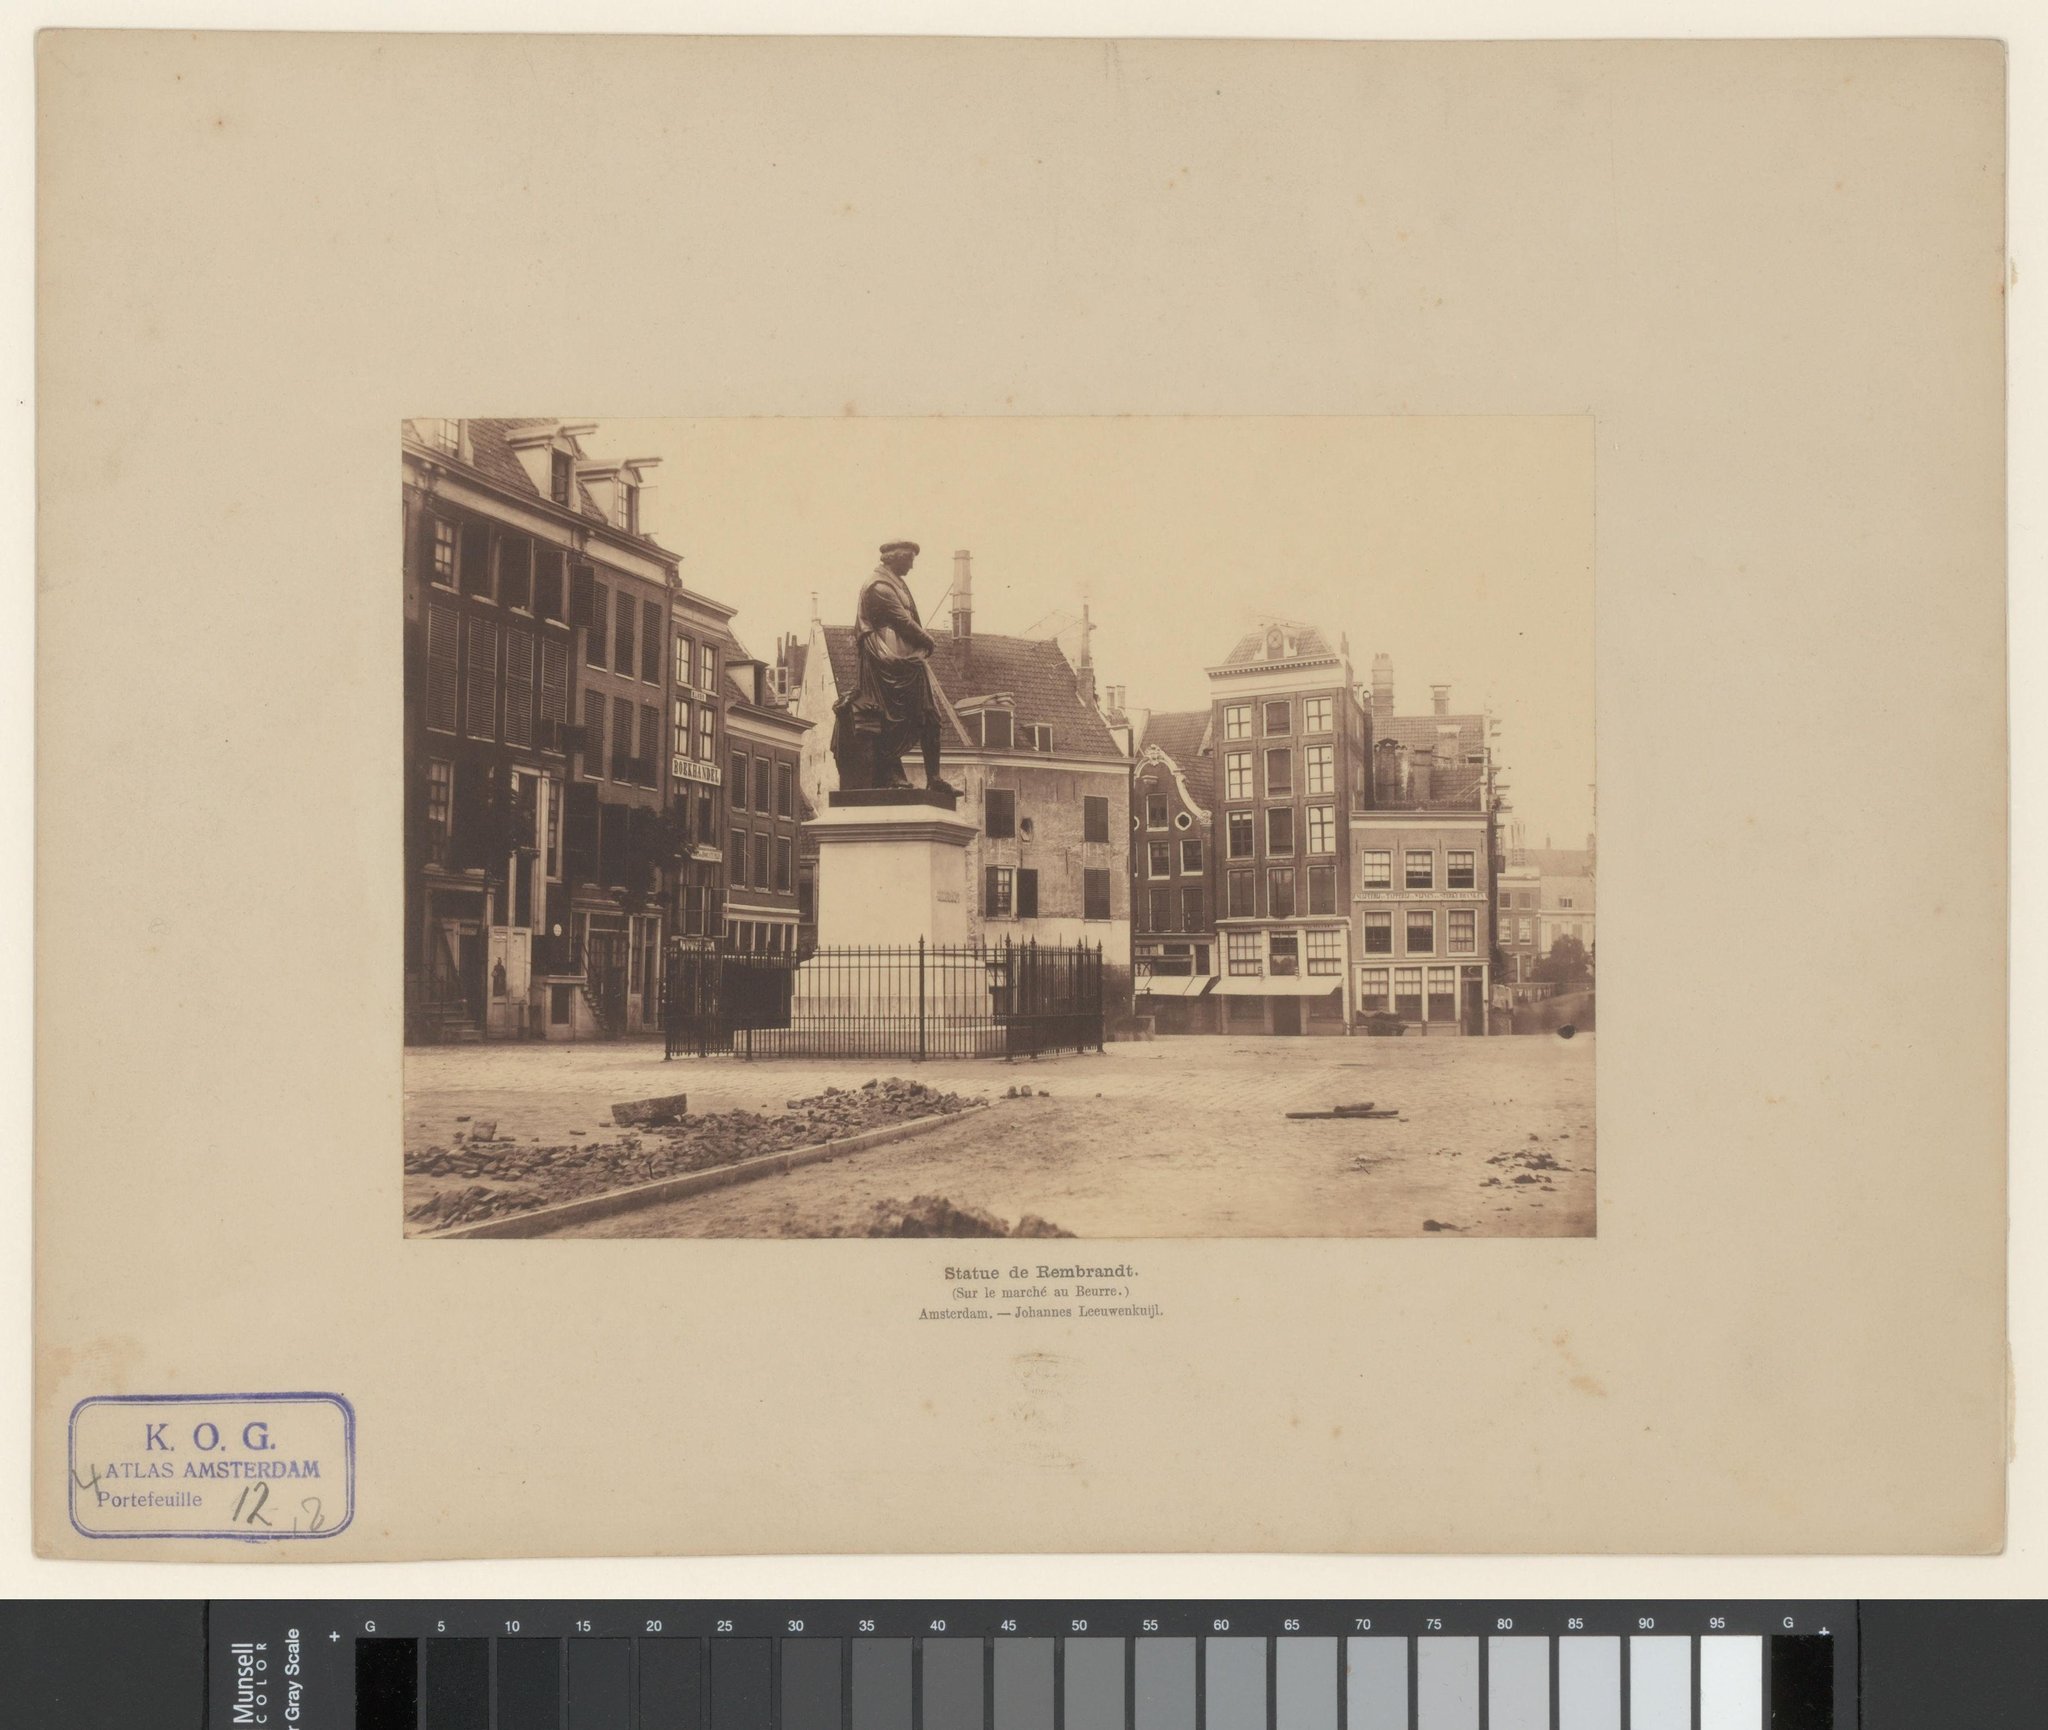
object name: photograph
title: Gezicht op het Rembrandtmonument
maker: johannes leeuwenkuijl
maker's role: boekhandelaar, fotograaf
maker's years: 1834-1886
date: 1852-1886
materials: cardboard, paper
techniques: albumen print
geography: amsterdam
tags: square, place, circus, etc., city-view in general; 'veduta', monument, statue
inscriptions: collector's mark: ‘12,8’ Lugt 1641b, check stamp: ‘[...] M&E / Photographie [...]’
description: Onderwerpsrubriek binnen de Atlas Amsterdam: Rembrandtplein (Botermarkt), Roeterseiland.